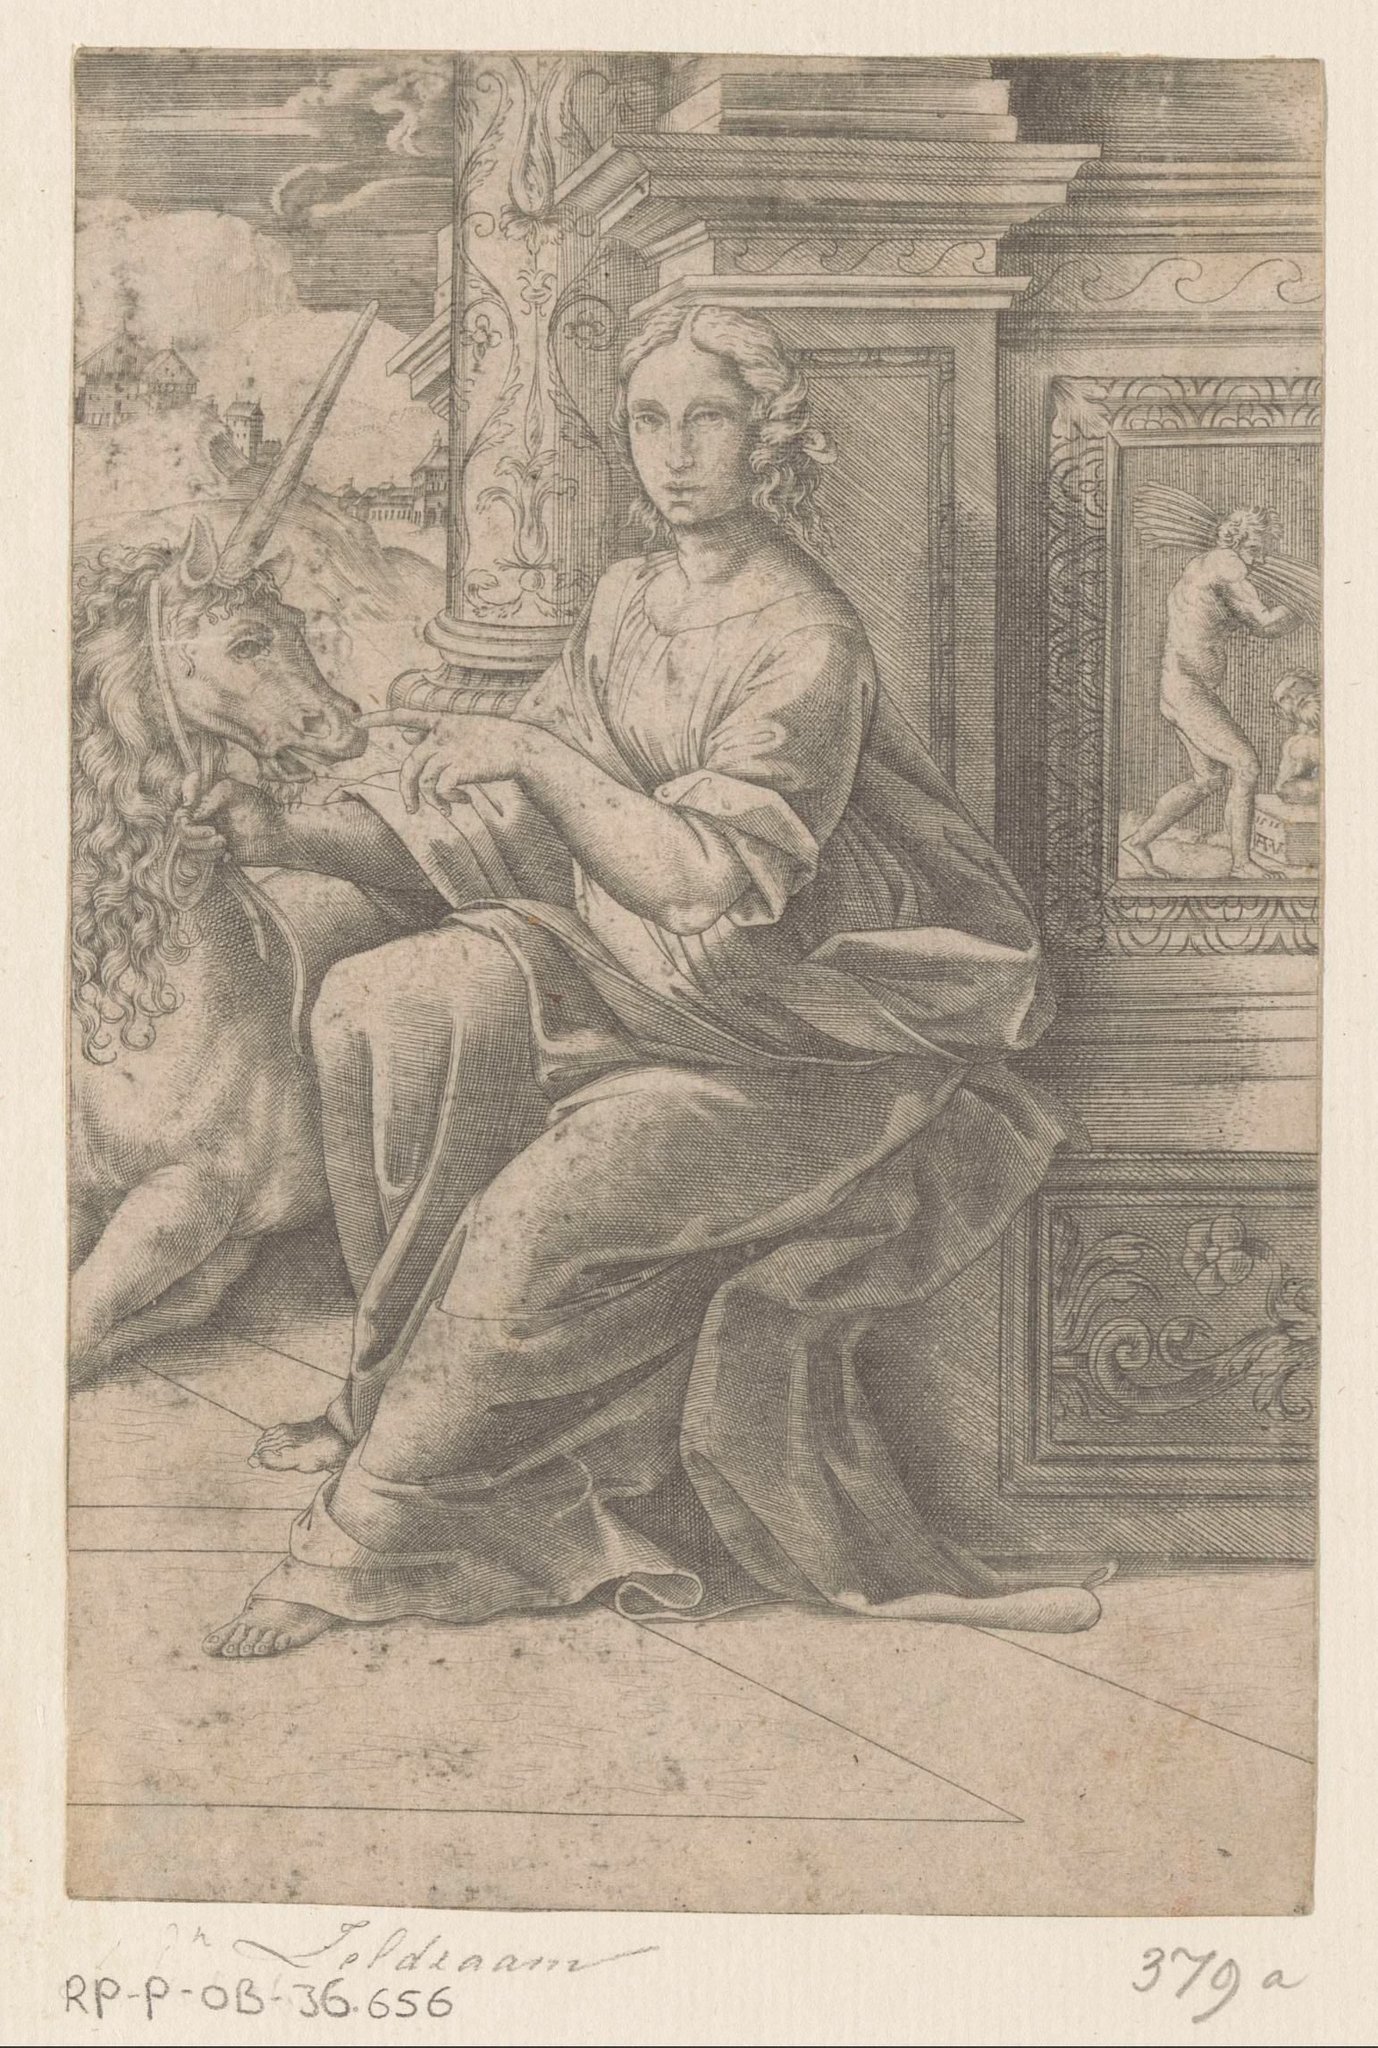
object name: print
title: Kuisheid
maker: agostino veneziano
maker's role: draughtsman, painter, print maker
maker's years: 1490-1536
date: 1516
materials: paper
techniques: engraving, etching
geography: italy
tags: unicorn, 'castità ', 'pudicitia', 'vergogna honesta' (ripa)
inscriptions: collector's mark: Lugt 12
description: Volgens Bartsch is deze prent naar ontwerp van Rafaël. Er zijn echter ook overeenkomsten met een tekening door Leonardo da Vinci in het British Museum te Londen (inv.nr. 1860,0616.98).